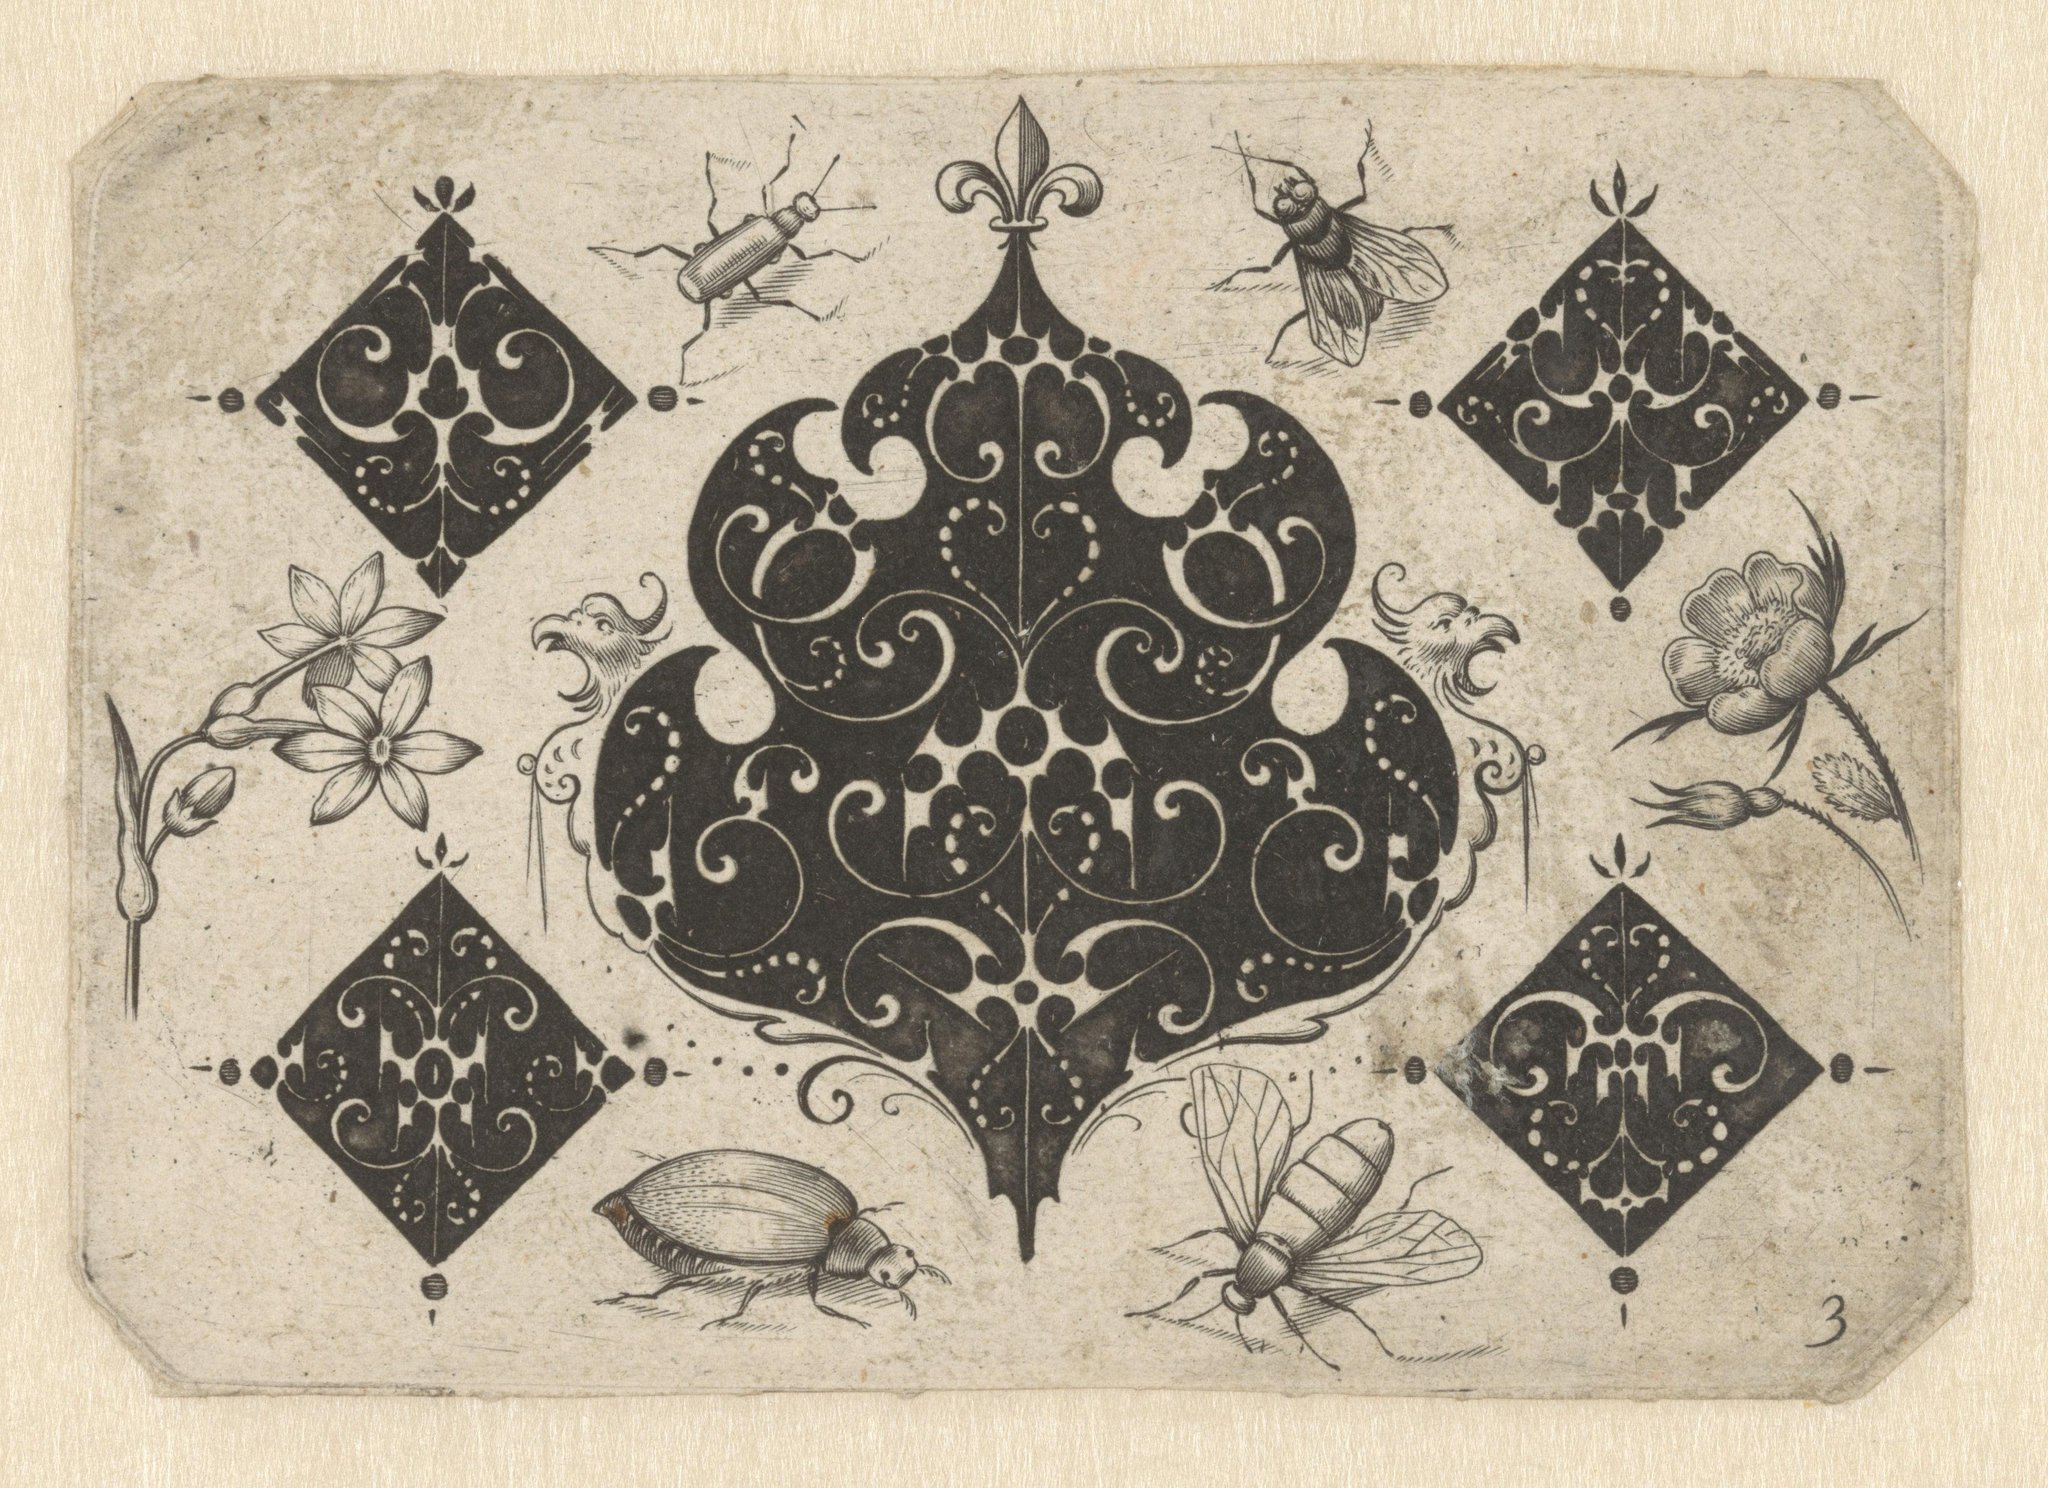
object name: ornament print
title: Ontwerp voor edelsmeedwerk met bloemen en dieren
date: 1614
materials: paper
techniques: engraving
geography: paris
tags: flowers, frequently used ornamental compositions, insects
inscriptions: collector's mark: Lugt 2760, collector's mark: Lugt 2228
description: Ontwerp voor edelsmeedwerk met bloemen en dieren. Tussen de ornamenten ook enkele insecten en bloemen. Rechtsonder genummerd:3. Eén van vier oblong ontwerpen voor edelsmeden, versierd met dieren, bloemen en figuren (nrs. 2, 3, 5, en 6 en uit een reeks van 7).